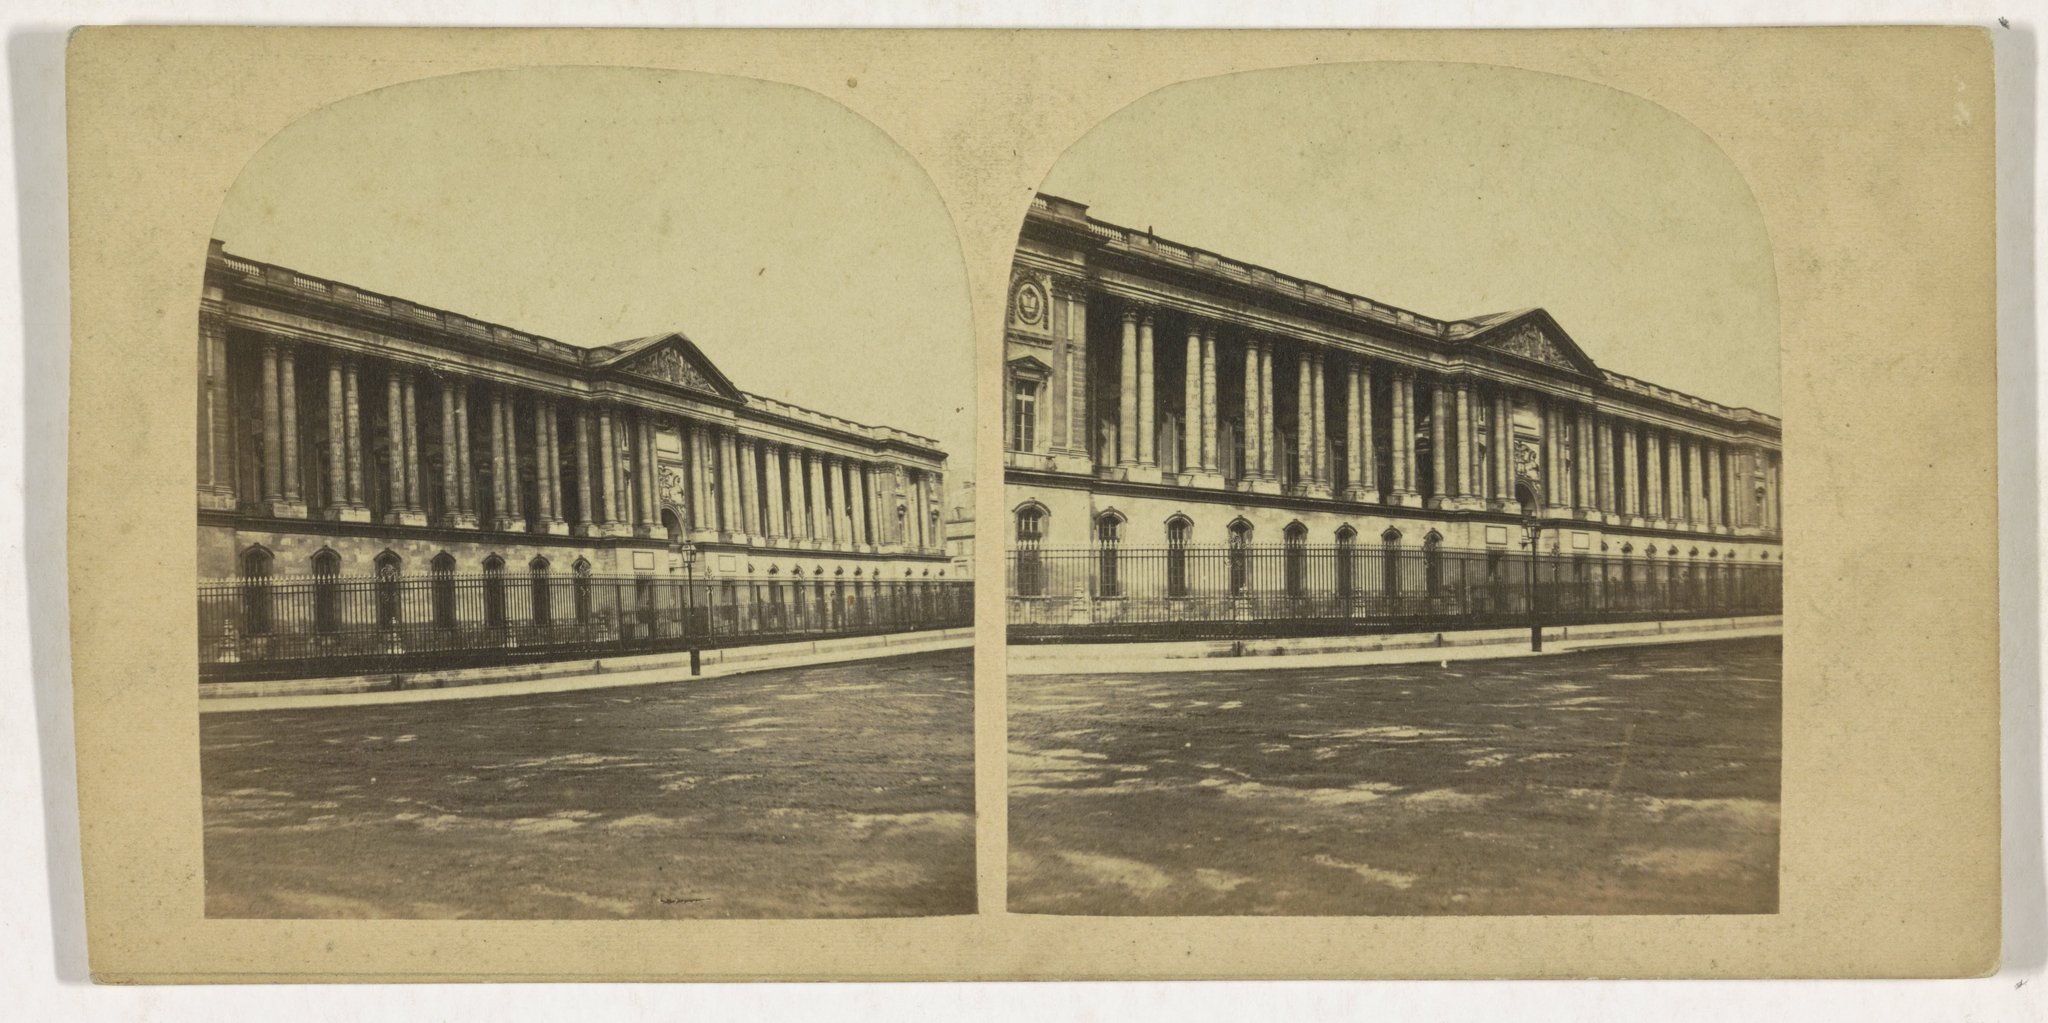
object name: stereograph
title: Gezicht op het Louvre, Parijs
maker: Anonymous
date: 1860-1870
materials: cardboard, paper, photographic support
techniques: albumen print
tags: paris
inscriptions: inscription: ‘H Louvre (?) Paris’, inscription: ‘A0042 €750’